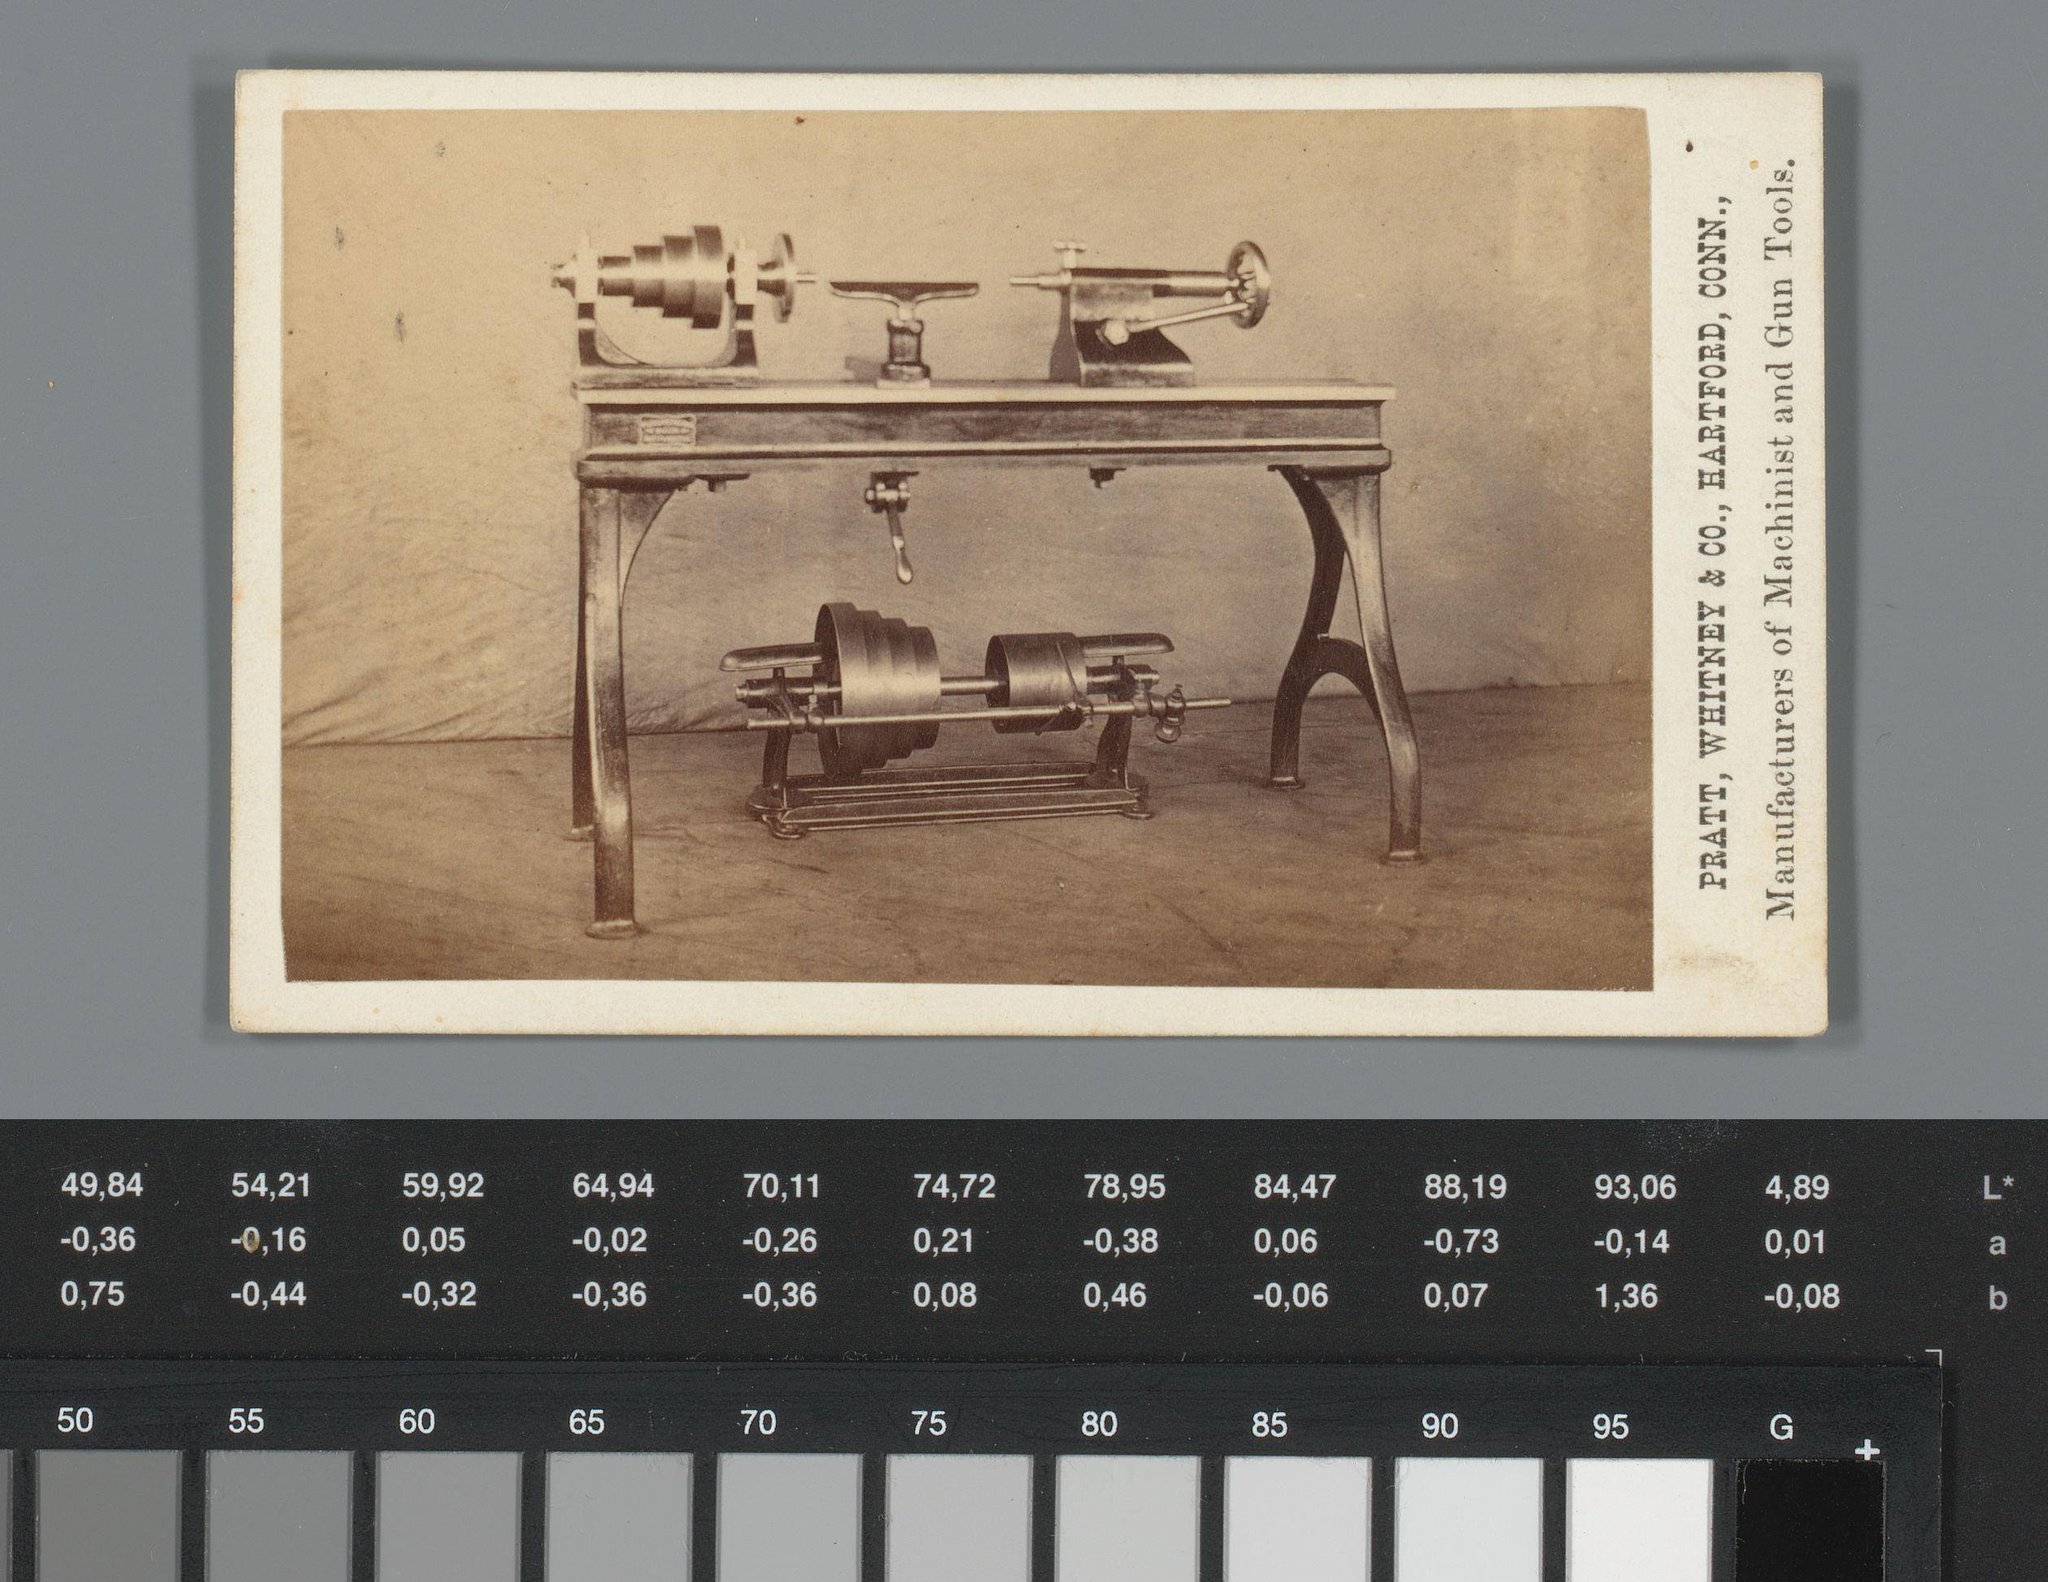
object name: carte de visite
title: Reclame voor een draaibank van Pratt, Whitney & Company in Hartford, Connecticut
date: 1850-1915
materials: cardboard, photographic support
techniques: albumen print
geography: hartford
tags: advertising, machines, engines ~ crafts and industries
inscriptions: inscription: ‘(...)/ Prescott & White,/ No. 368 Main Street,/ Hartford, Conn../ (...)’